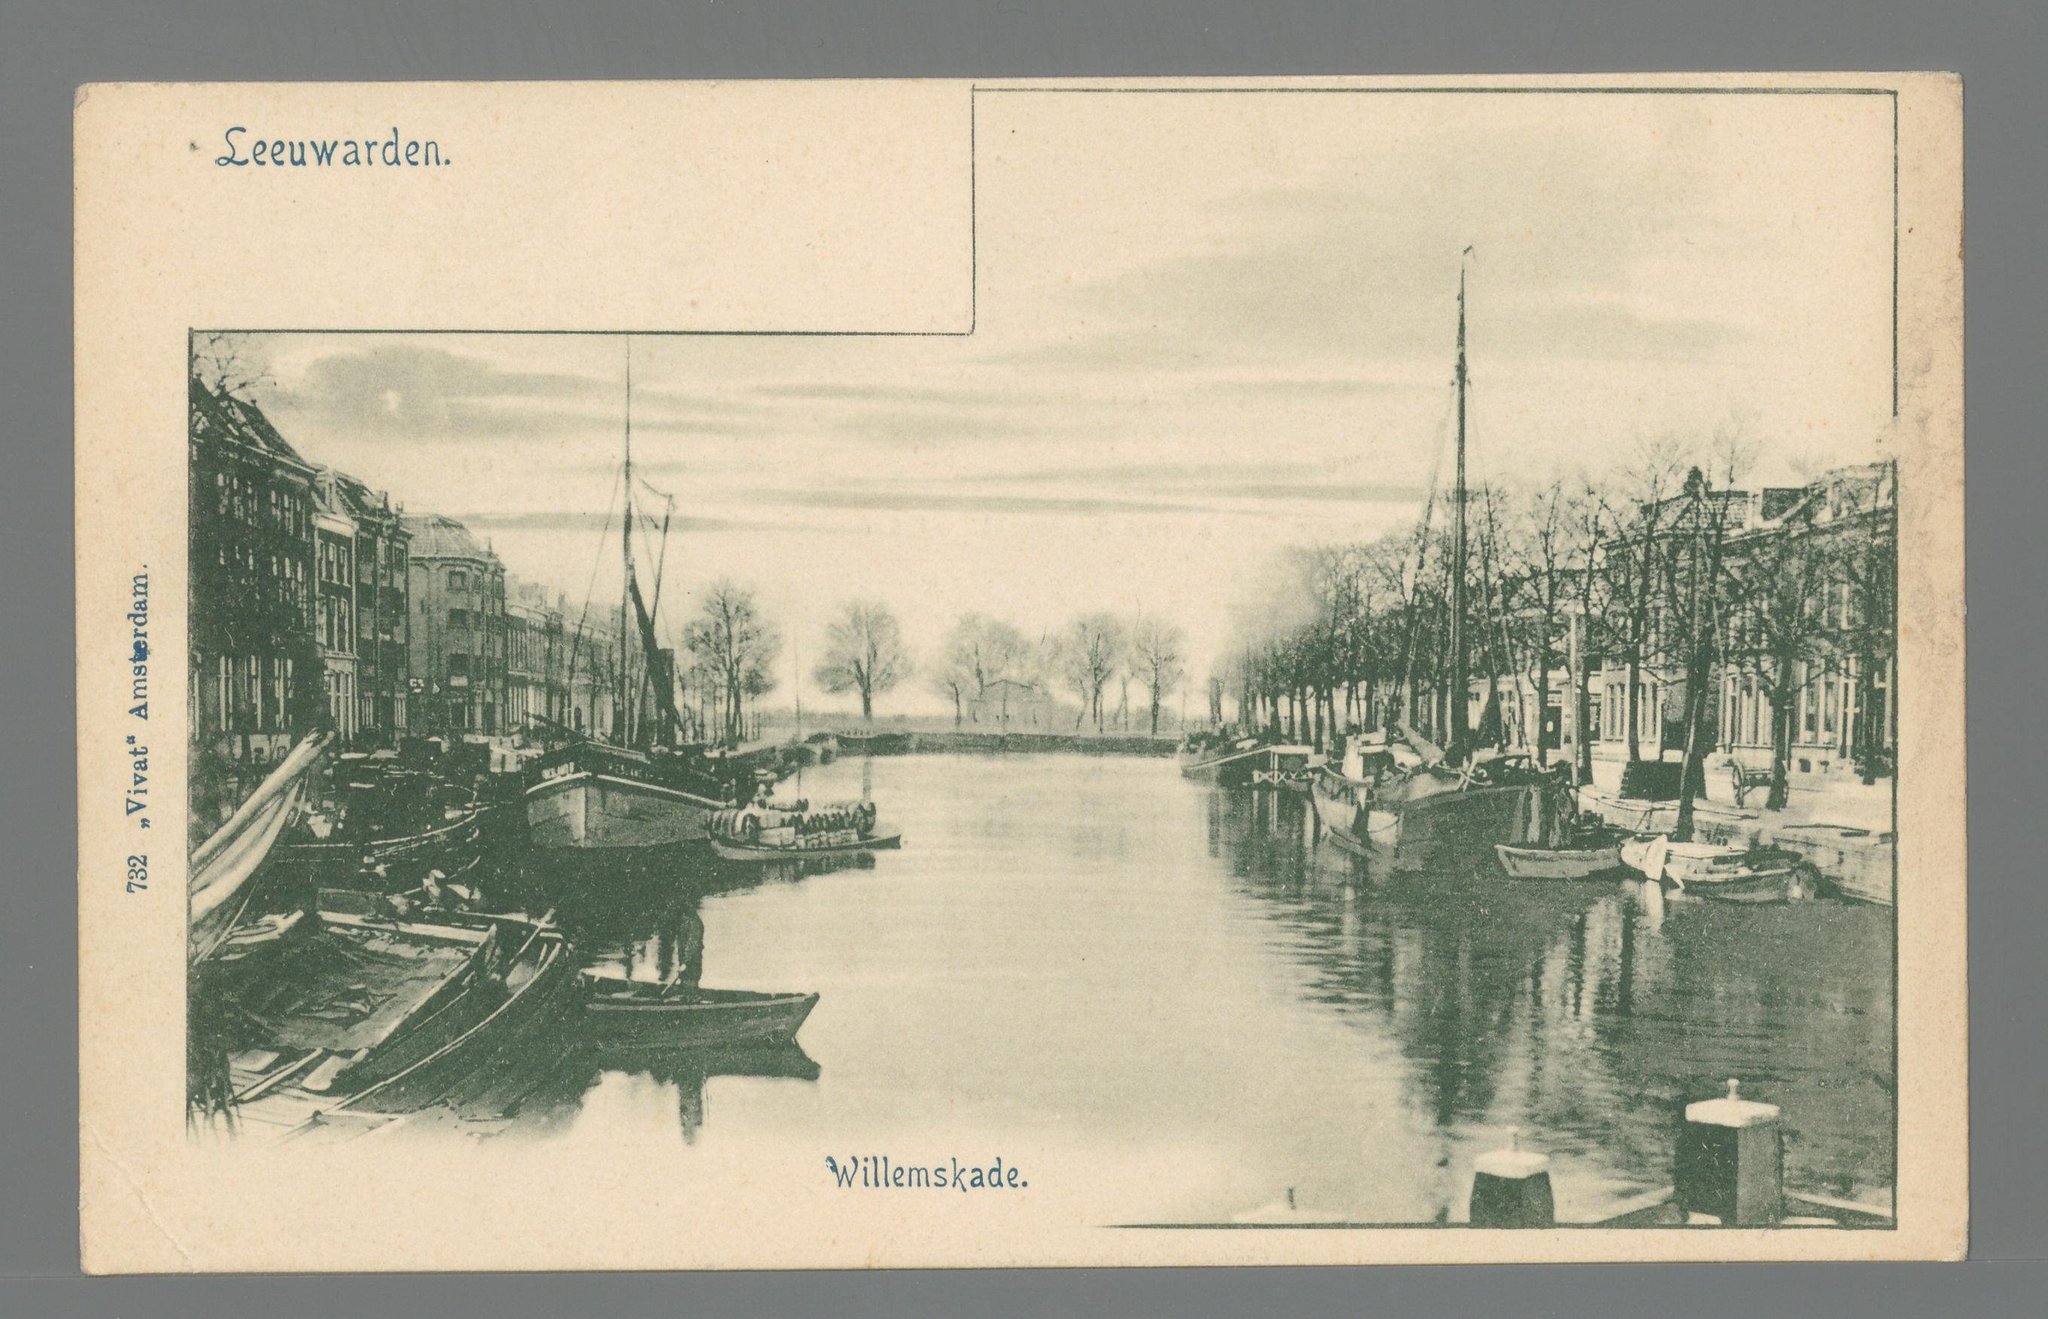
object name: ansichtkaart, prentbriefkaart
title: Leeuwarden. Willemskade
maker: Anonymous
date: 1892-1905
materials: cardboard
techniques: photograph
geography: leeuwarden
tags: sailing-ship, sailing-boat, canal, street